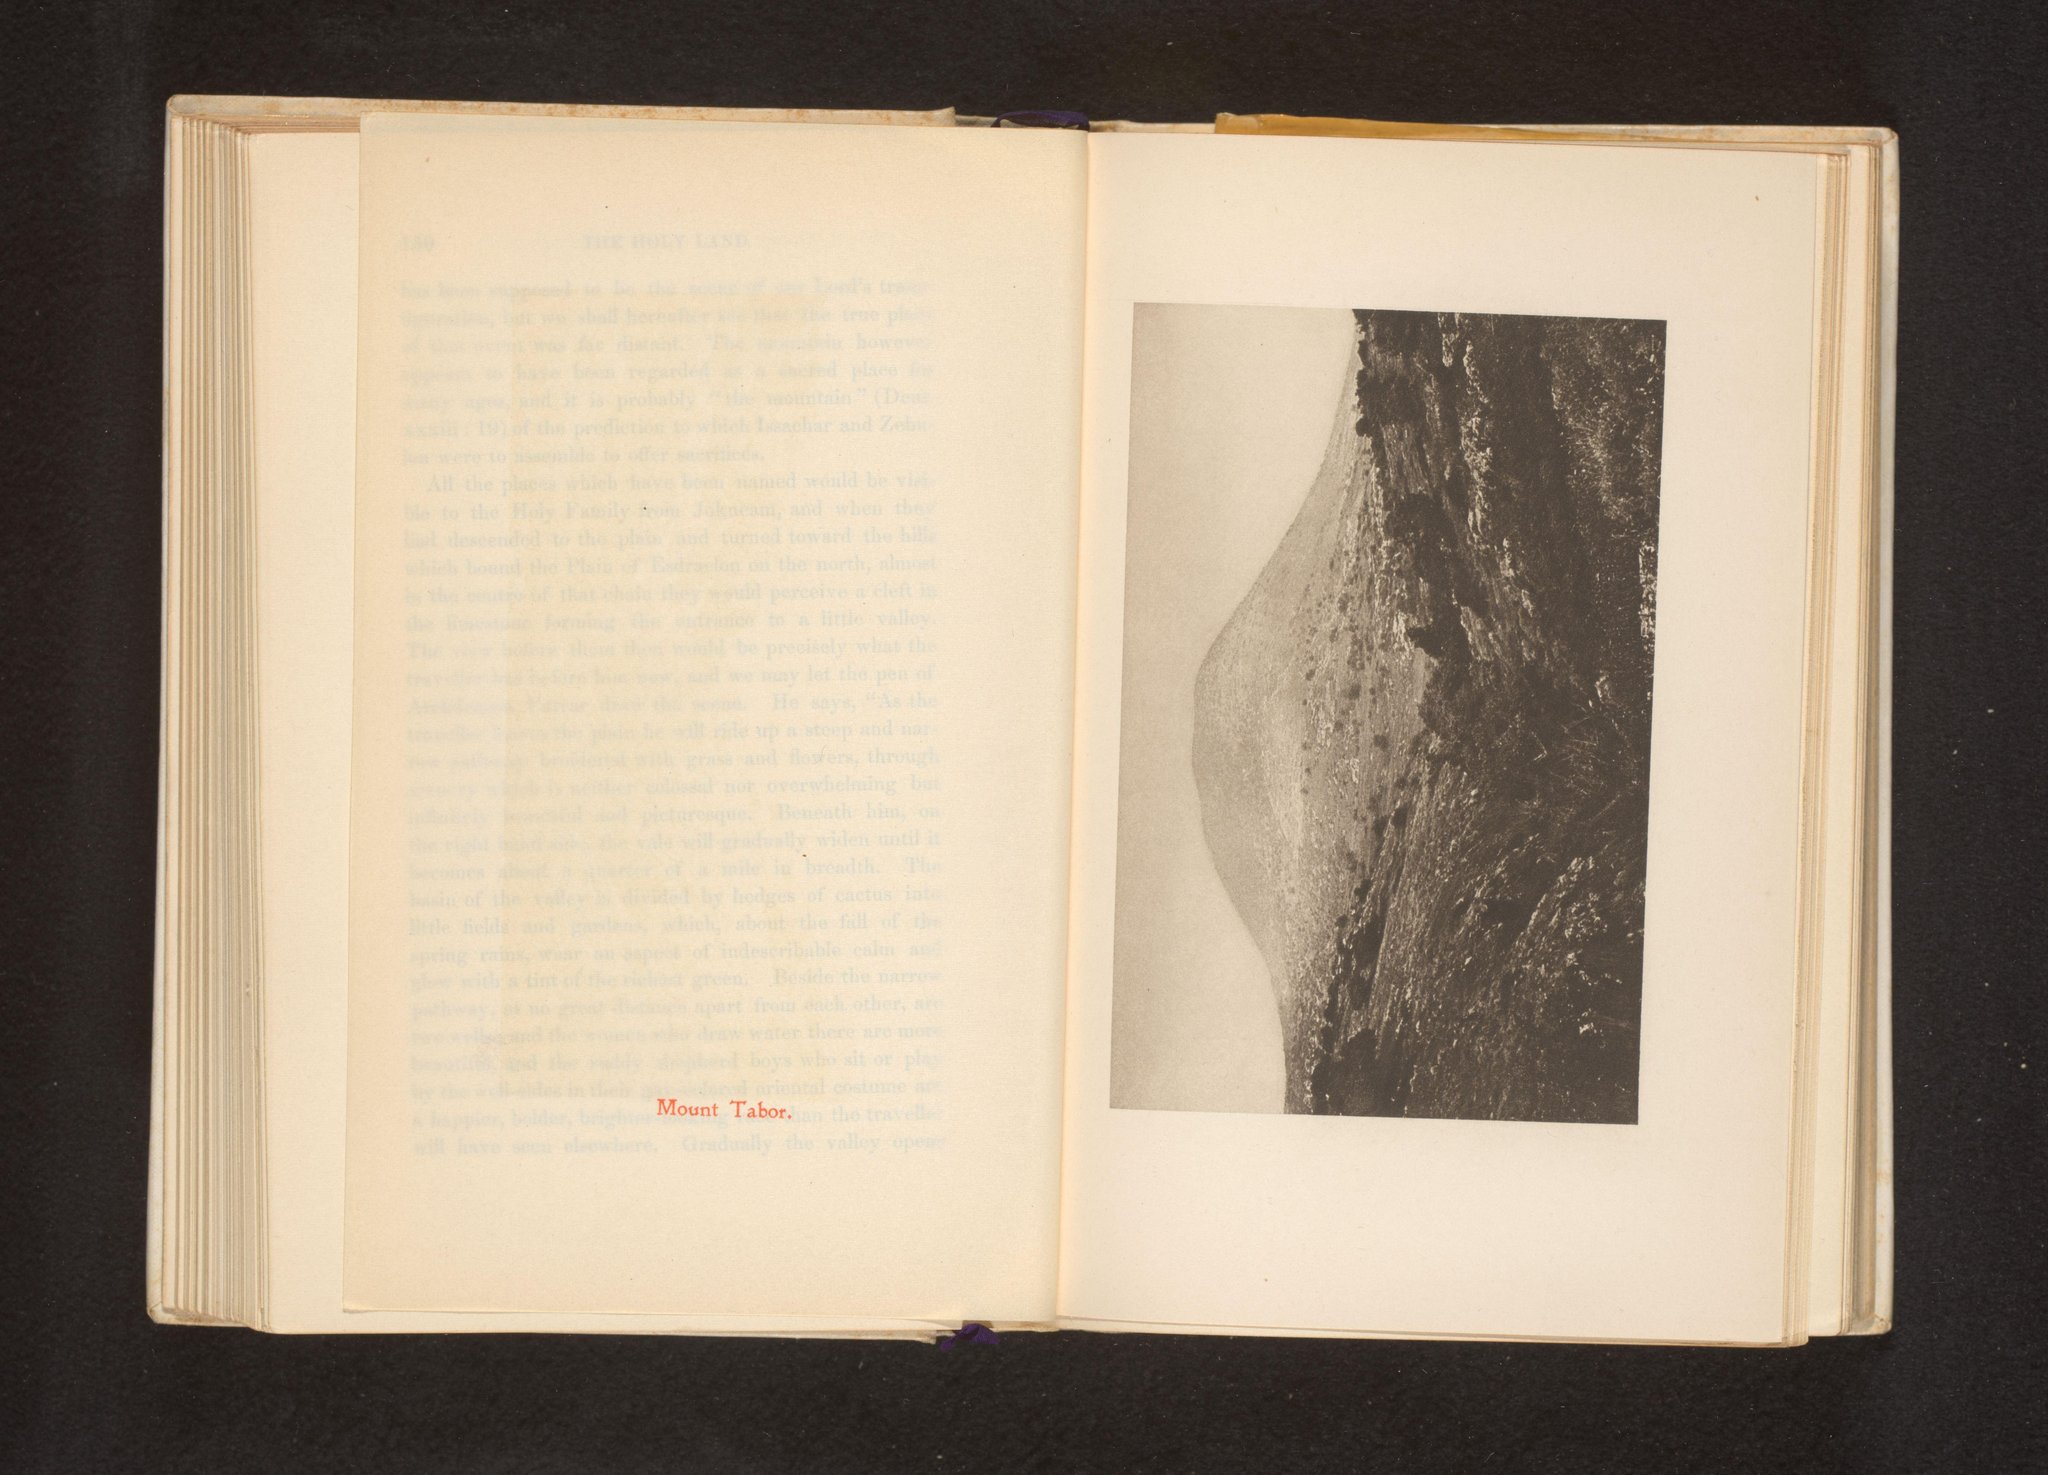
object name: page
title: Gezicht op de berg Tabor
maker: Anonymous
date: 1890-1900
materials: paper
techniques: photoaquatint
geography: israel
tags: mountains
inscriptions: title: ‘Mount Tabor.’